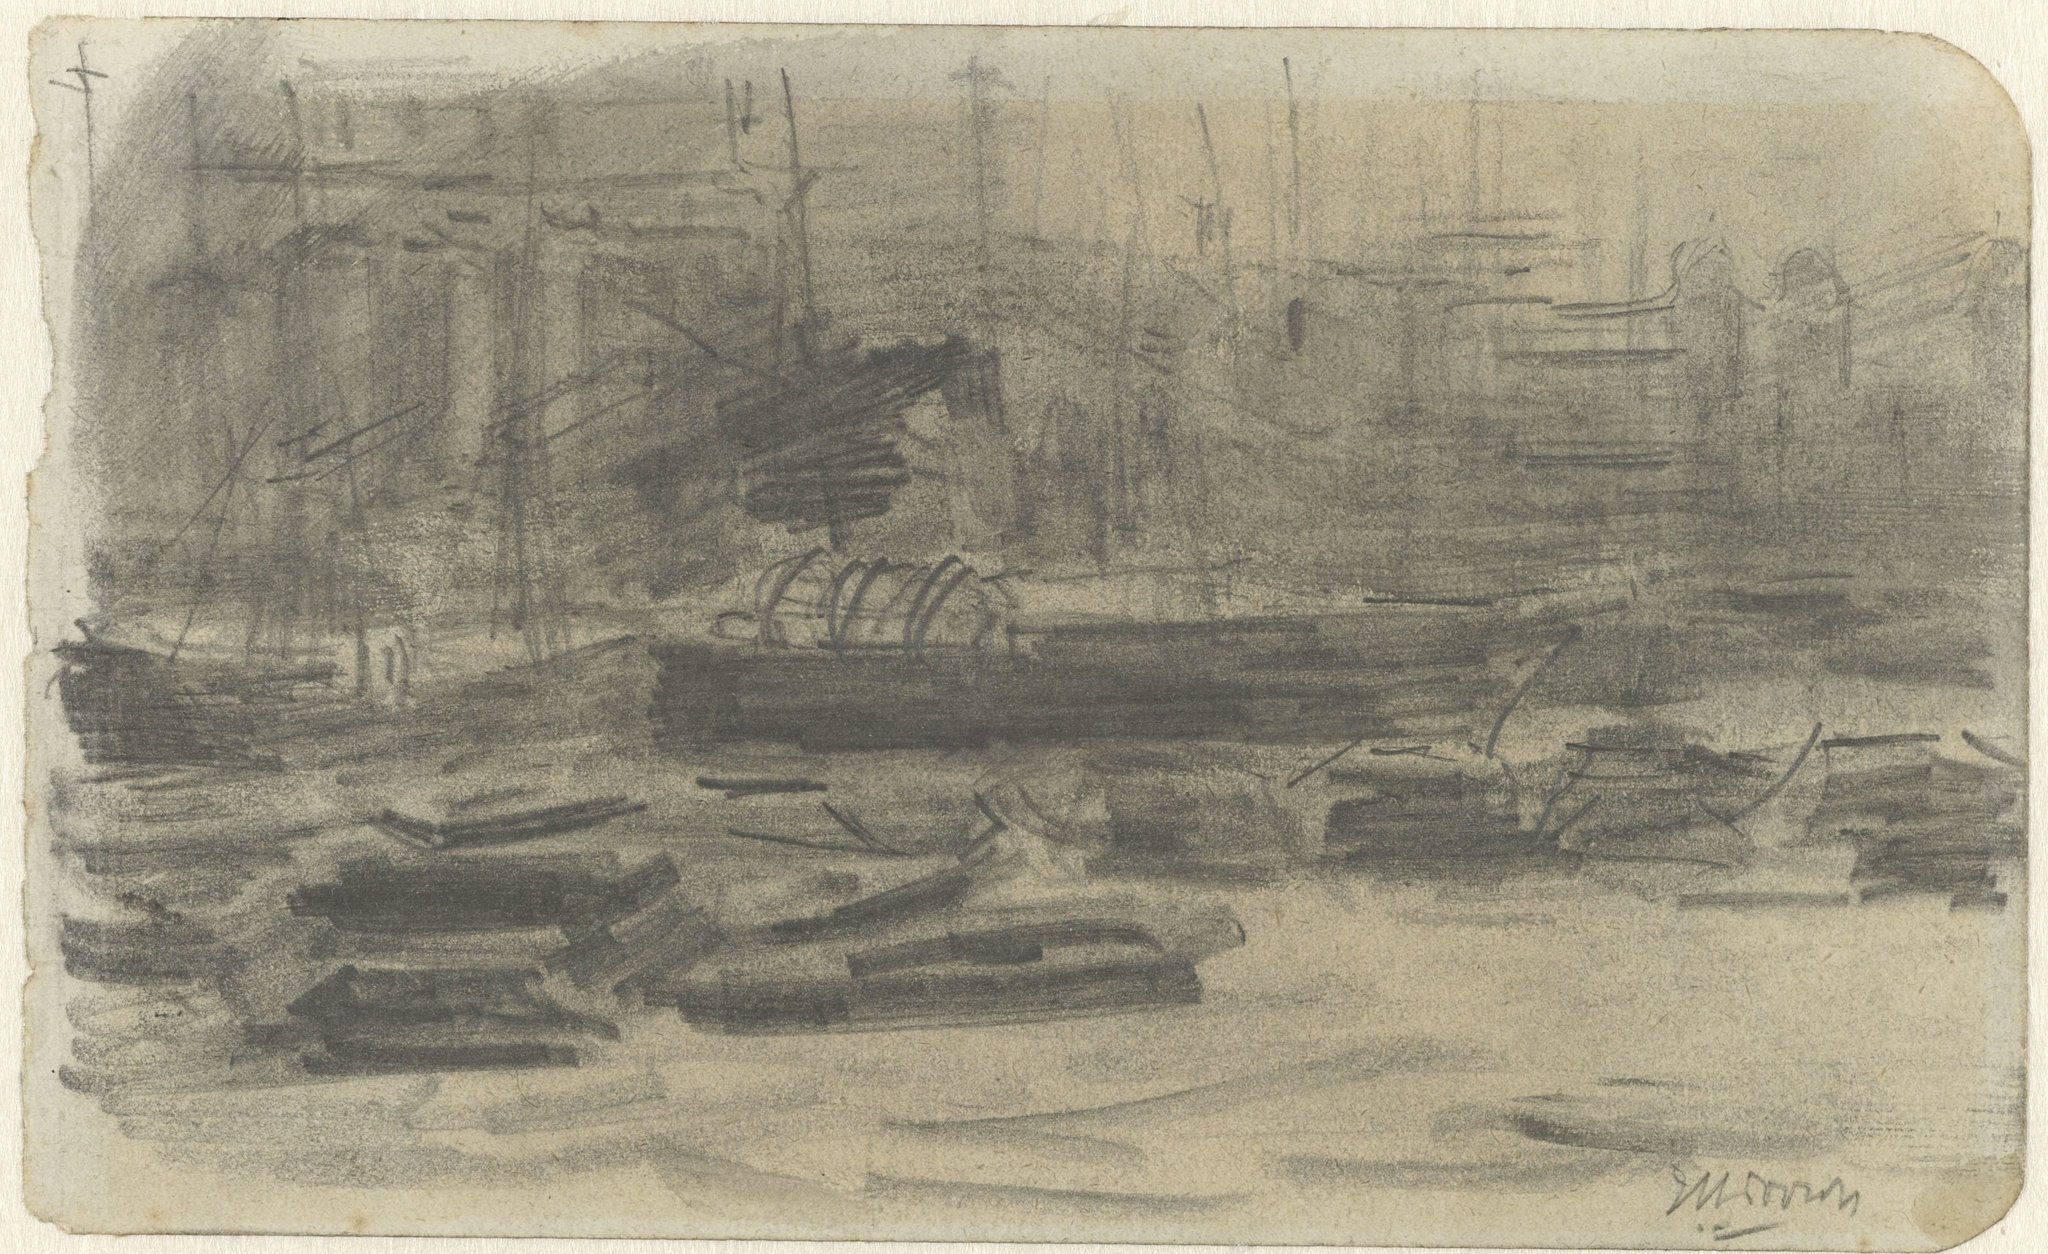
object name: drawing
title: Schepen op de Theems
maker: jan toorop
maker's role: draughtsman, painter, print maker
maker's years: 1858-1928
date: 1868-1928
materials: paper, pencil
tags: canals, waters (in city), london, thames